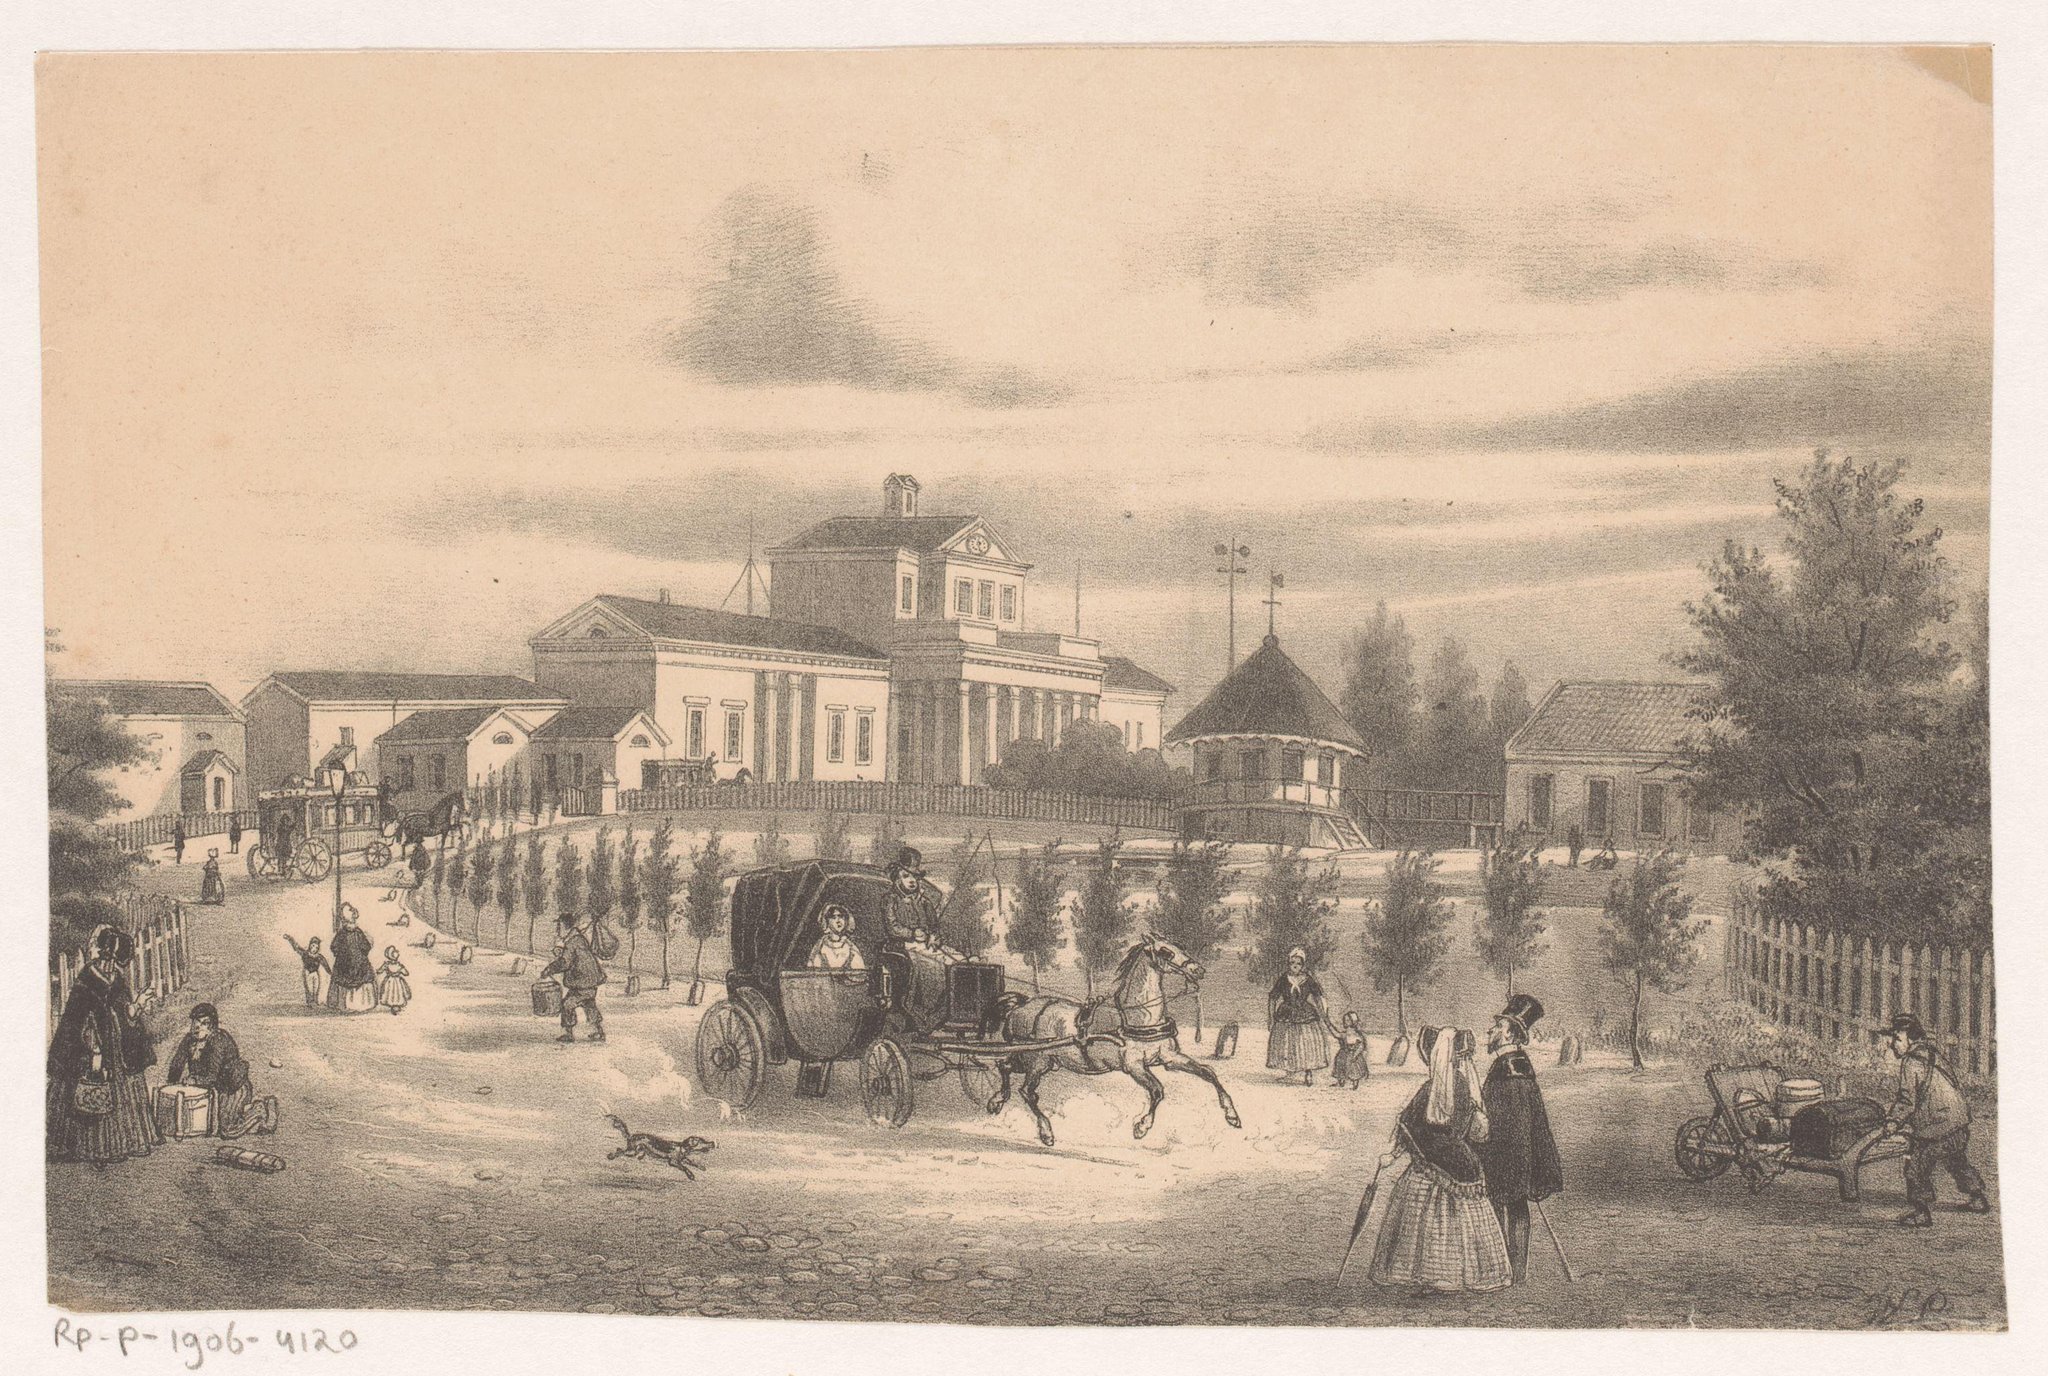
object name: print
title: Gezicht op het station in Den Haag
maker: hendrik wilhelmus last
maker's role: print maker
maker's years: 1817-1873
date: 1827-1873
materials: paper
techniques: lithograph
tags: four-wheeled vehicle drawn by one animal, station; shelter (railway, tramway), the hague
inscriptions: collector's mark: Lugt 2228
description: Op de weg naar het station wandelaars en rijtuigen.